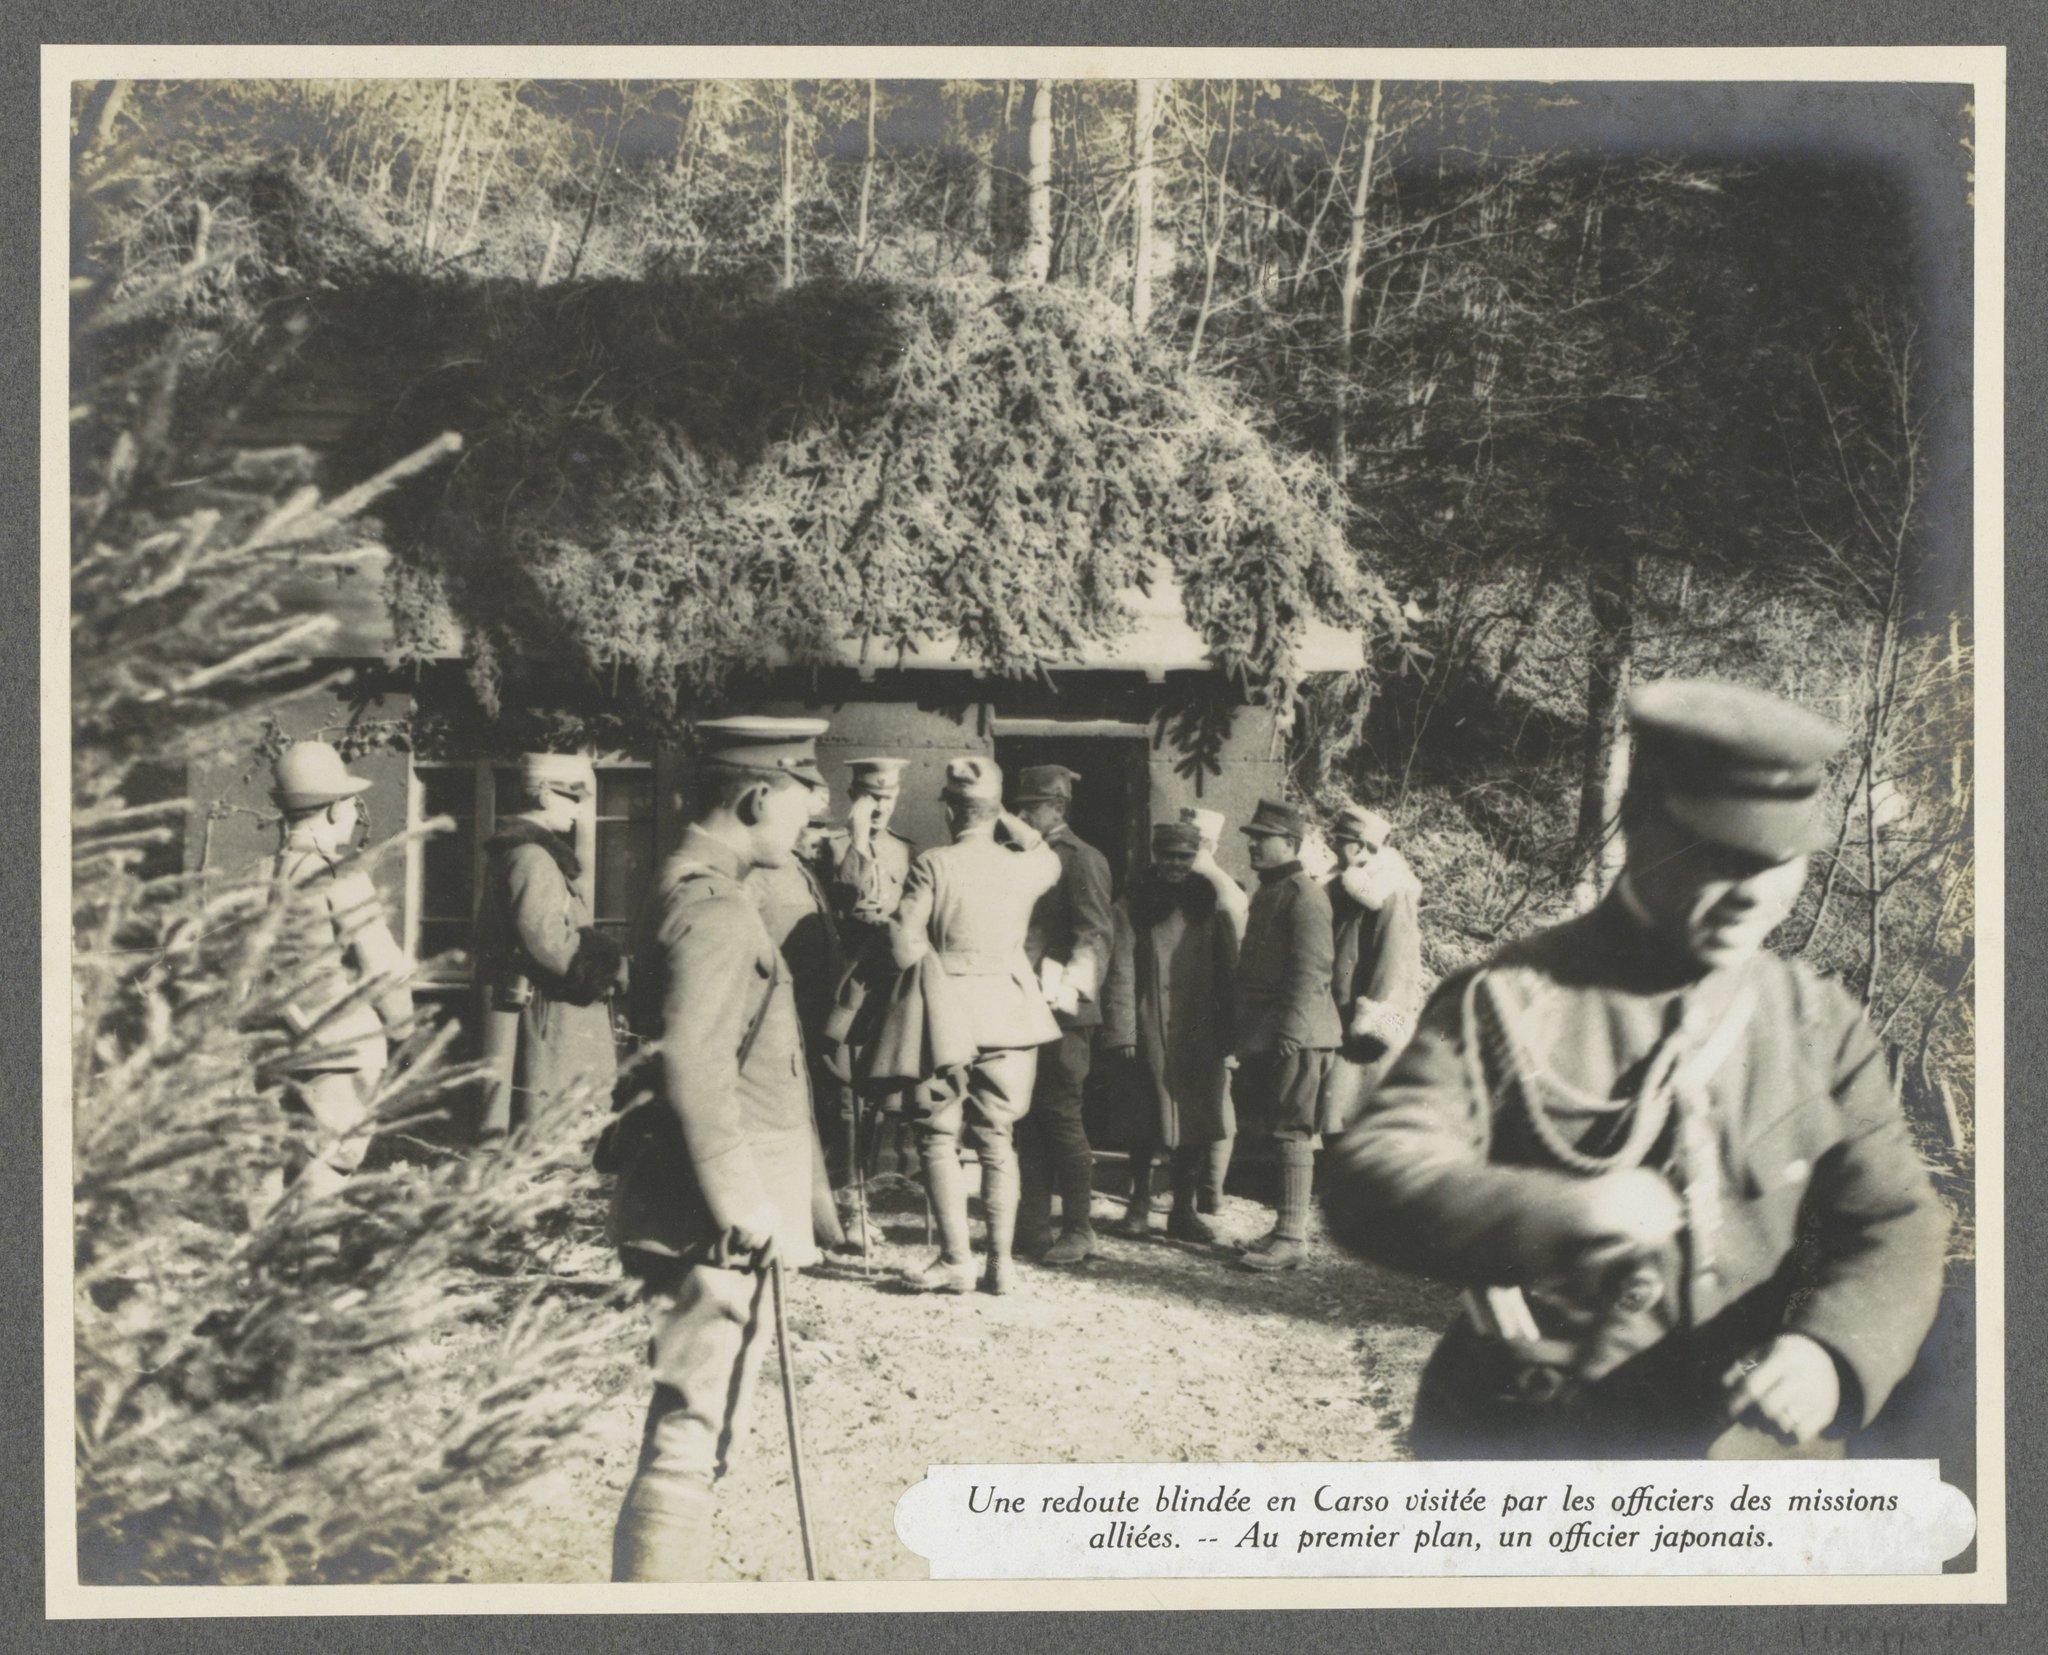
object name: photograph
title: Une redoute blindée en Carso visitée par les officiers des missions alliées. -- Au premier plan, un officier japonais.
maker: henri de rothschild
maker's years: 1872-1947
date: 1916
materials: photographic support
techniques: gelatin silver print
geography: karst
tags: war (+ land forces), shelter ~ military service (+ warfare in forest), review, inspection (of company, unit, troop) (+ land forces)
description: Militairen van diverse nationaliteiten begroeten elkaar voor de ingang van een gecamoufleerde verschansing. Het zijnn officieren van Engeland, Frankrijk, Rusland, Japan en Italië. Op de voorgrond rechts een Japanse officier. Onderdeel van Fotoalbum Medische missie H. de Rothschild naar het Italiaanse front 1916.